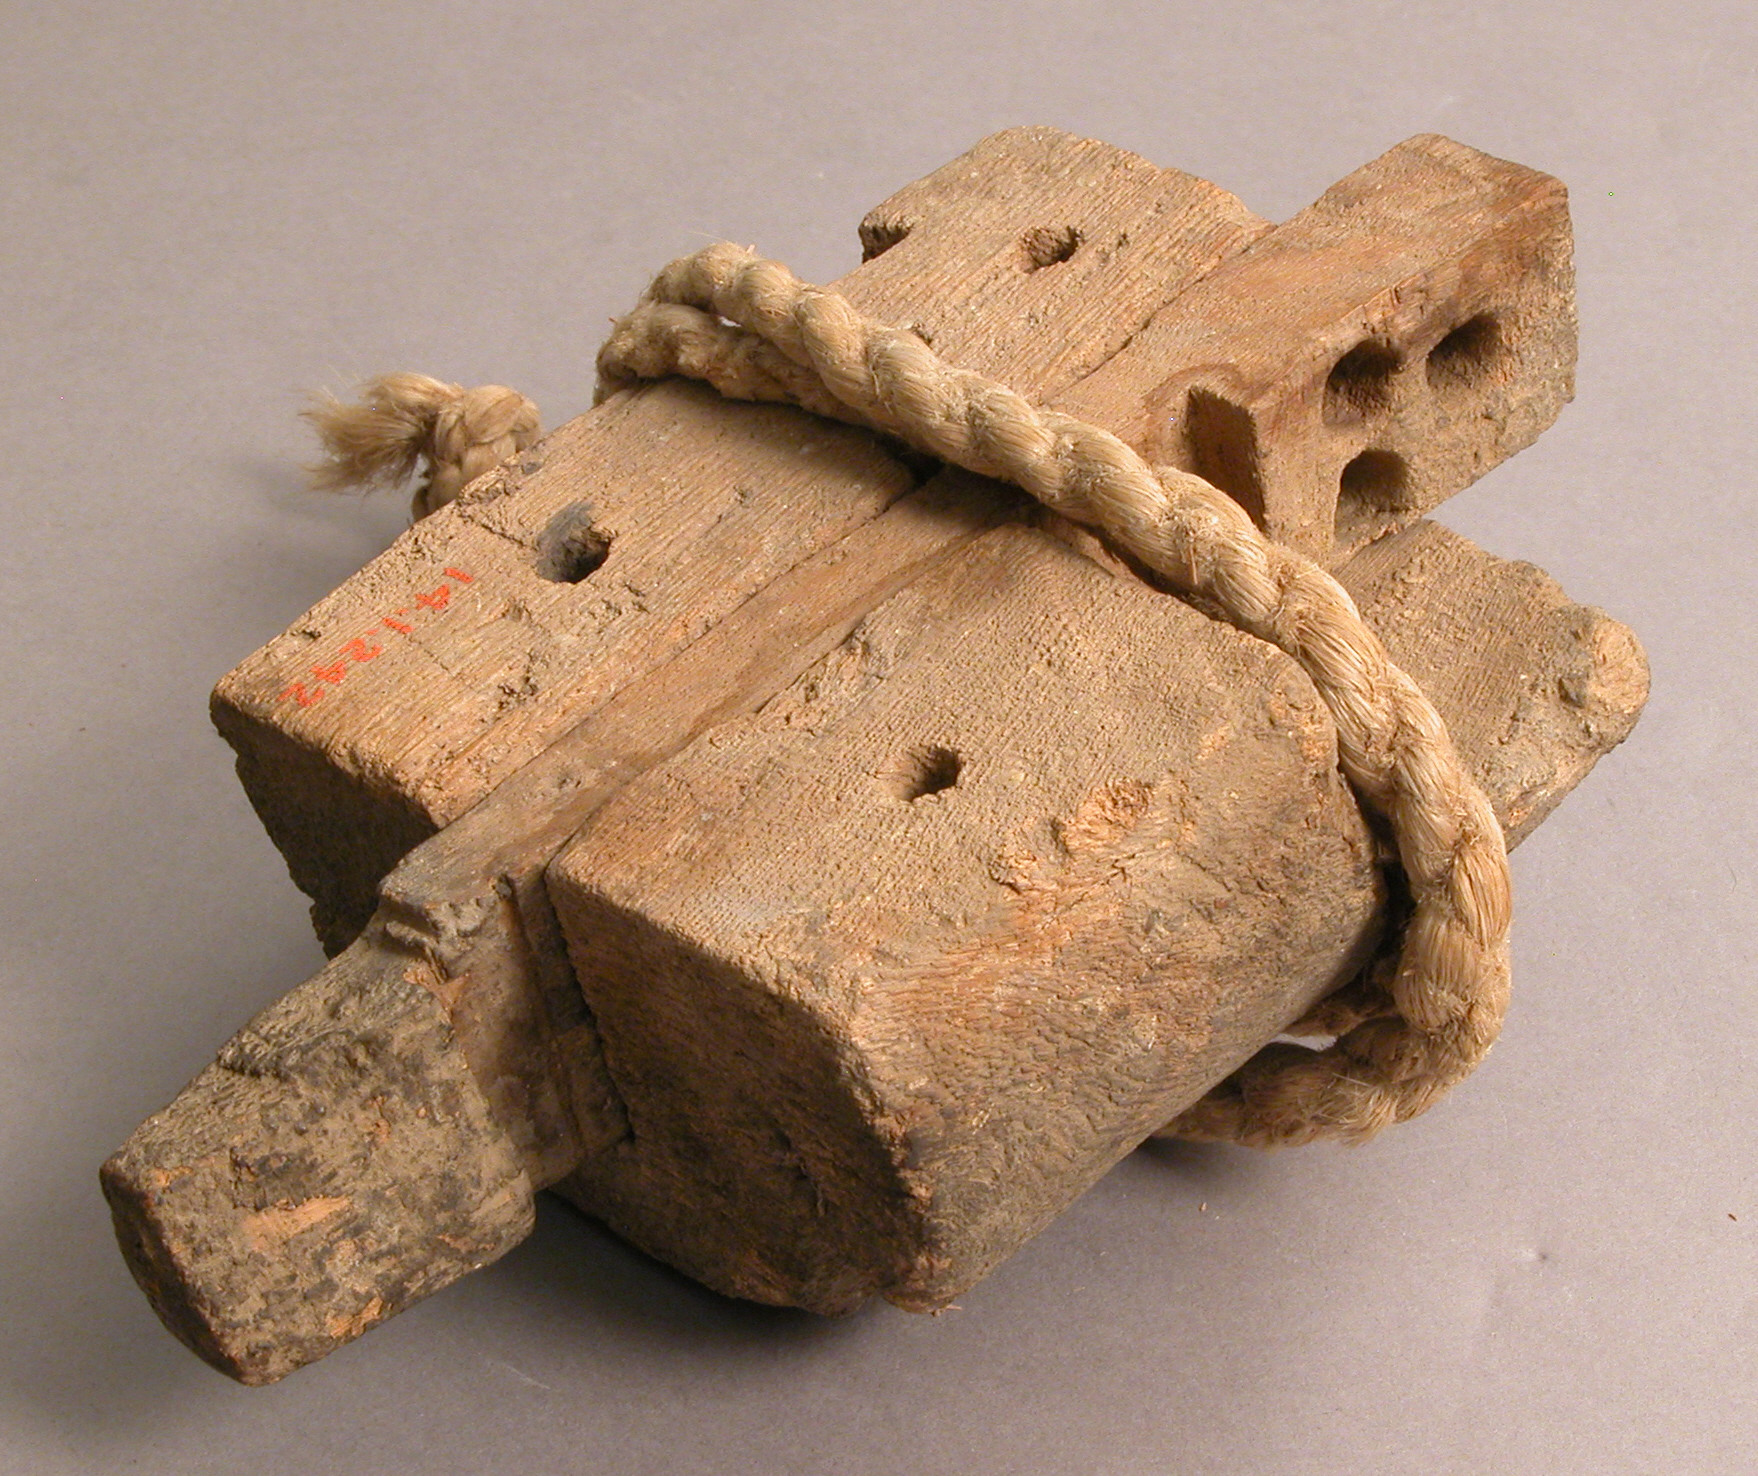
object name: lock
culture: coptic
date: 580-640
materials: fiber, wood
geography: egypt